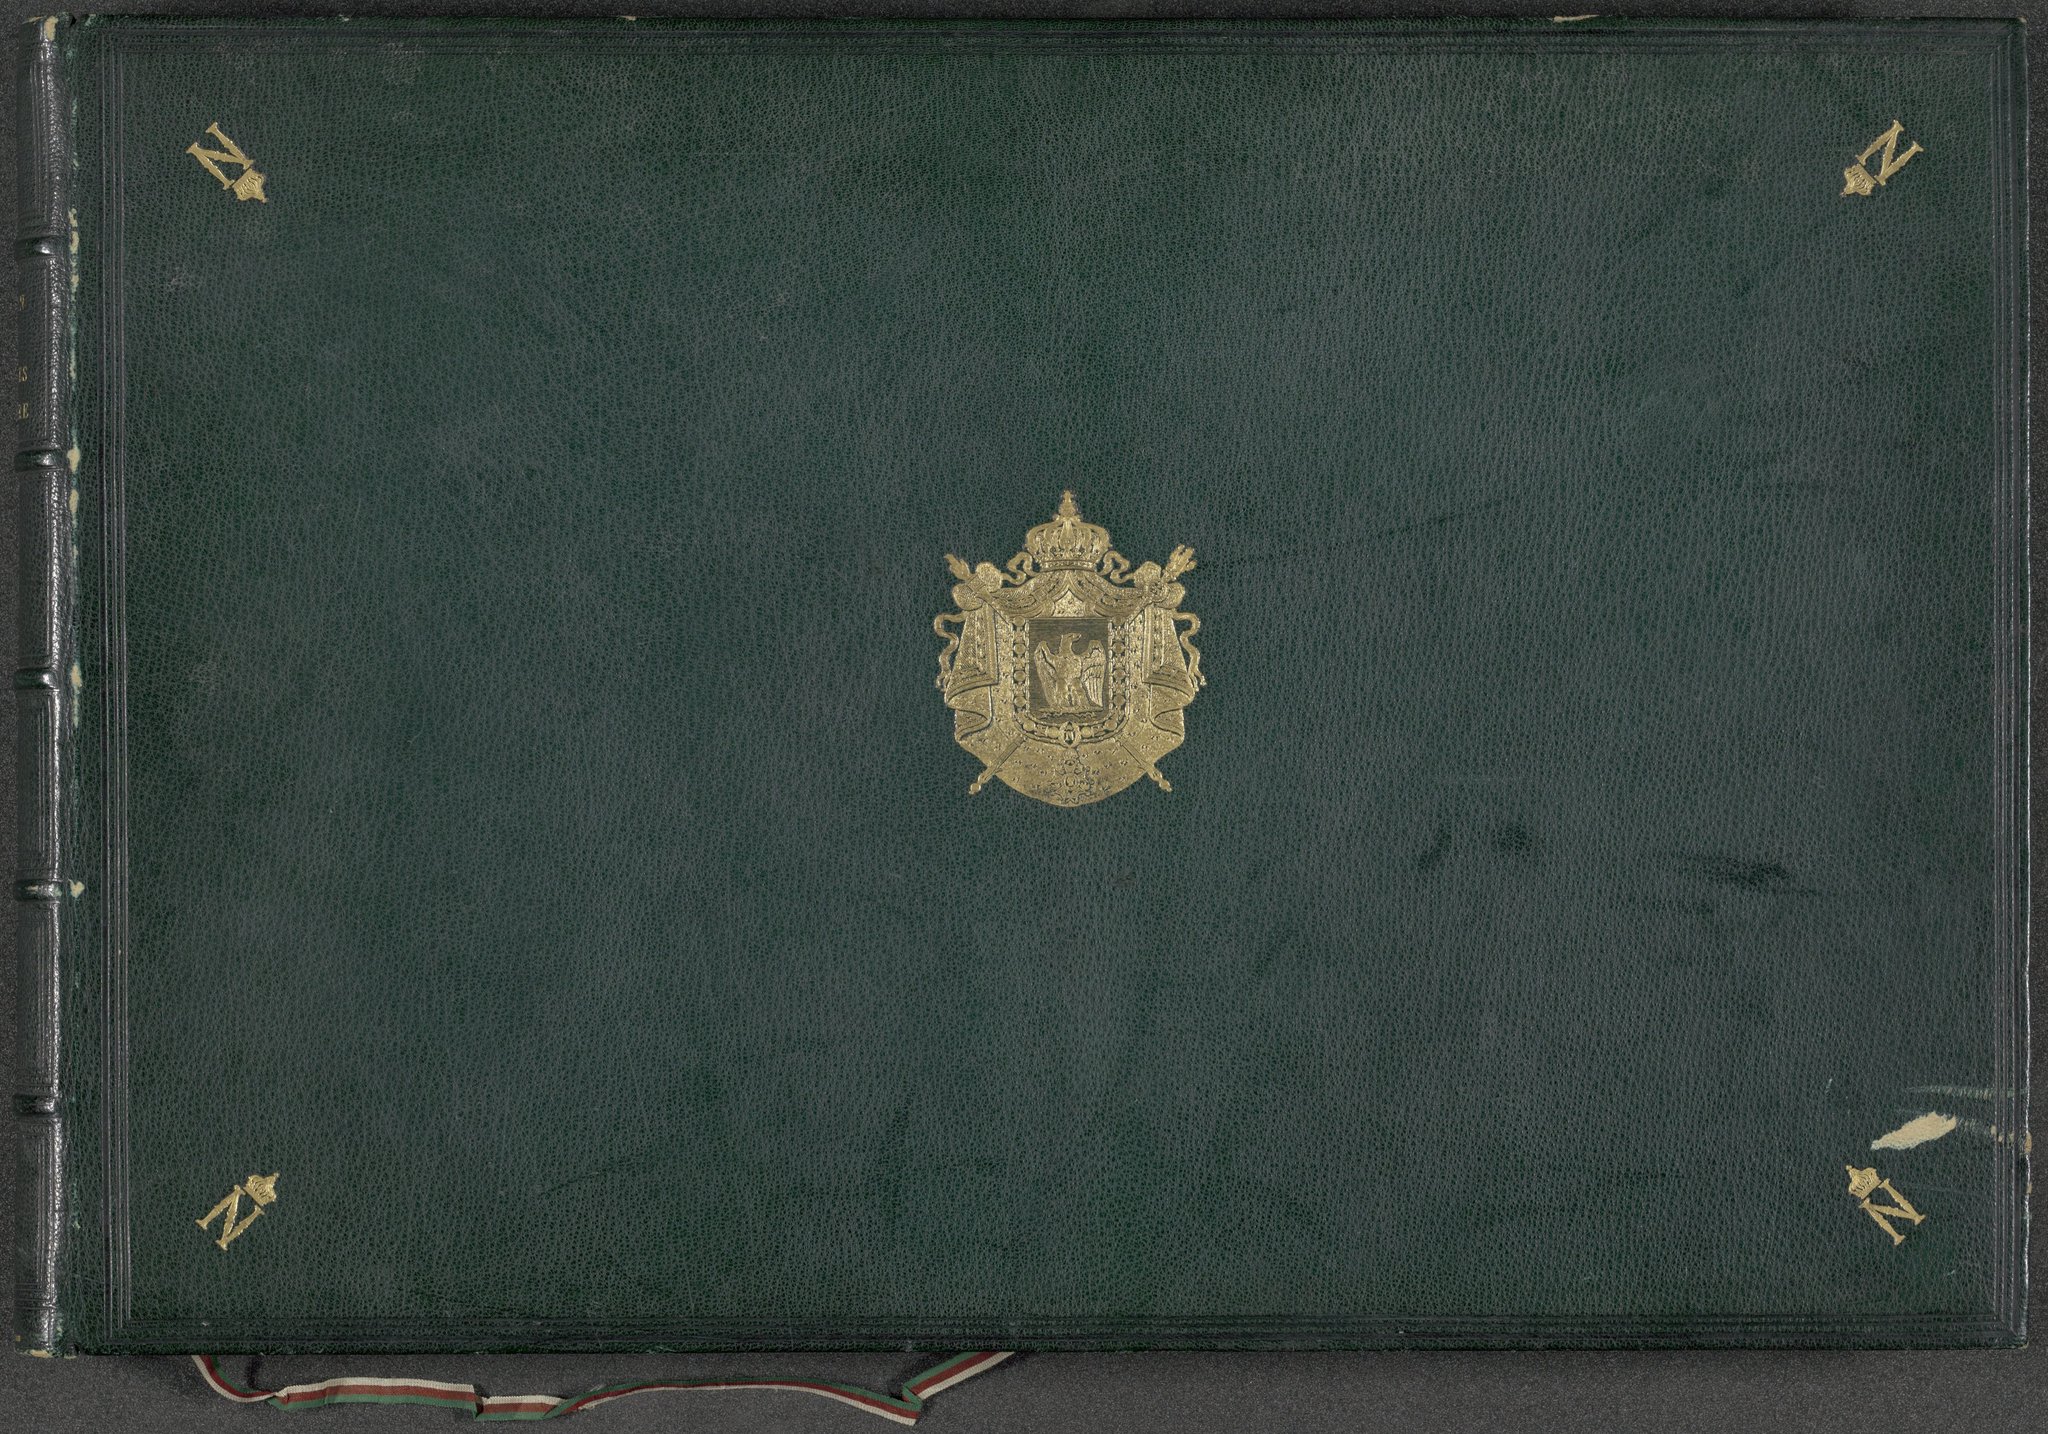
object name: photograph album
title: Réunion des Tuileries au Louvre, tome IV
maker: édouard denis baldus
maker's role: fotograaf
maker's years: 1813-1889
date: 1854-1857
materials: cardboard, leather, paper, photographic support, textile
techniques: engraving, salted paper print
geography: paris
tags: permanent exhibition, museum, paris, tuileries palace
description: Fotoalbum in groen leren omslag. Op de voor- en achterzijde prijkt het wapenschild van de Franse keizer Napoleon III, in de hoeken zijn monogram. Op de rugband wordt de titel vermeld en het deelnummer. De schutbladen zijn van groen changeant met een randversiering van Franse lelies in gouddruk. Het album bevat 99 bladen met goud op snee die elk één tot drie foto's bevatten. Het album maakt deel uit van een ensemble van vier waarmee de bouw van het nieuwe Louvre tussen 1854 en 1857 stap voor stap werd gedocumenteerd in opdracht van de Franse regering. De albums werden als representatie-exemplaren aangeboden aan de keizer, bevriende staatshoofden, ministers (zoals het exemplaar van het Rijksmuseum) en bibliotheken. Er werden 36 van dergelijke sets samengesteld, elk met ongeveer 550 foto's. Slechts vier ensembles zijn bewaard gebleven.